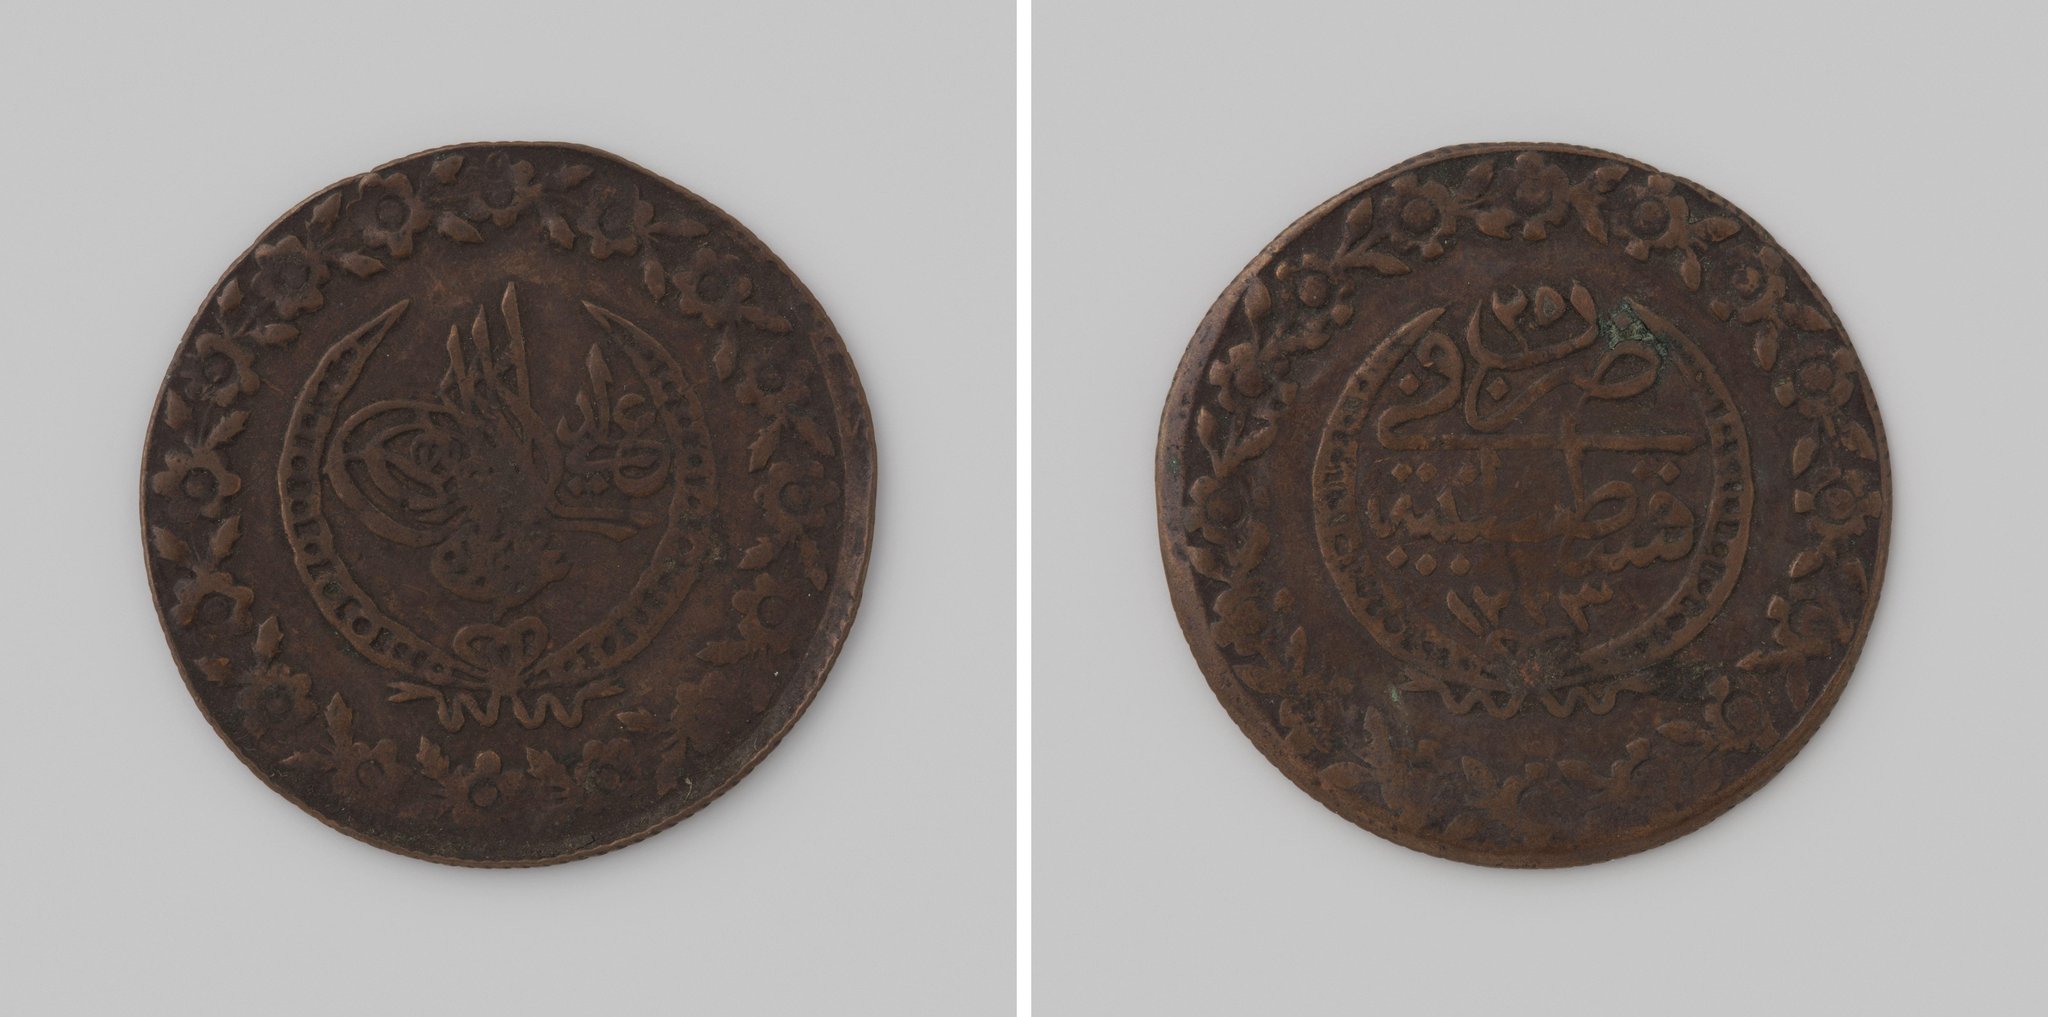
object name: coin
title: 100 para uit Turkije van sultan Mahmud II, regeringsjaar 25 [=1832]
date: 1832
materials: silver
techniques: striking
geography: constantinople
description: Koper-zilveren munt. Voorzijde: binnen bloemenrand tussen twee samengebonden halve manen tughra met rechts daarvan opschrift: adli. Keerzijde: binnen bloemenrand tussen twee samengebonden halve manen in Arabische letters drieregelig opschrift met muntplaats-aanduiding: Constantinopel. Boven in opschrift regeringsjaar: 25. Onderaan jaar van aantreden: 1223 [=1808].